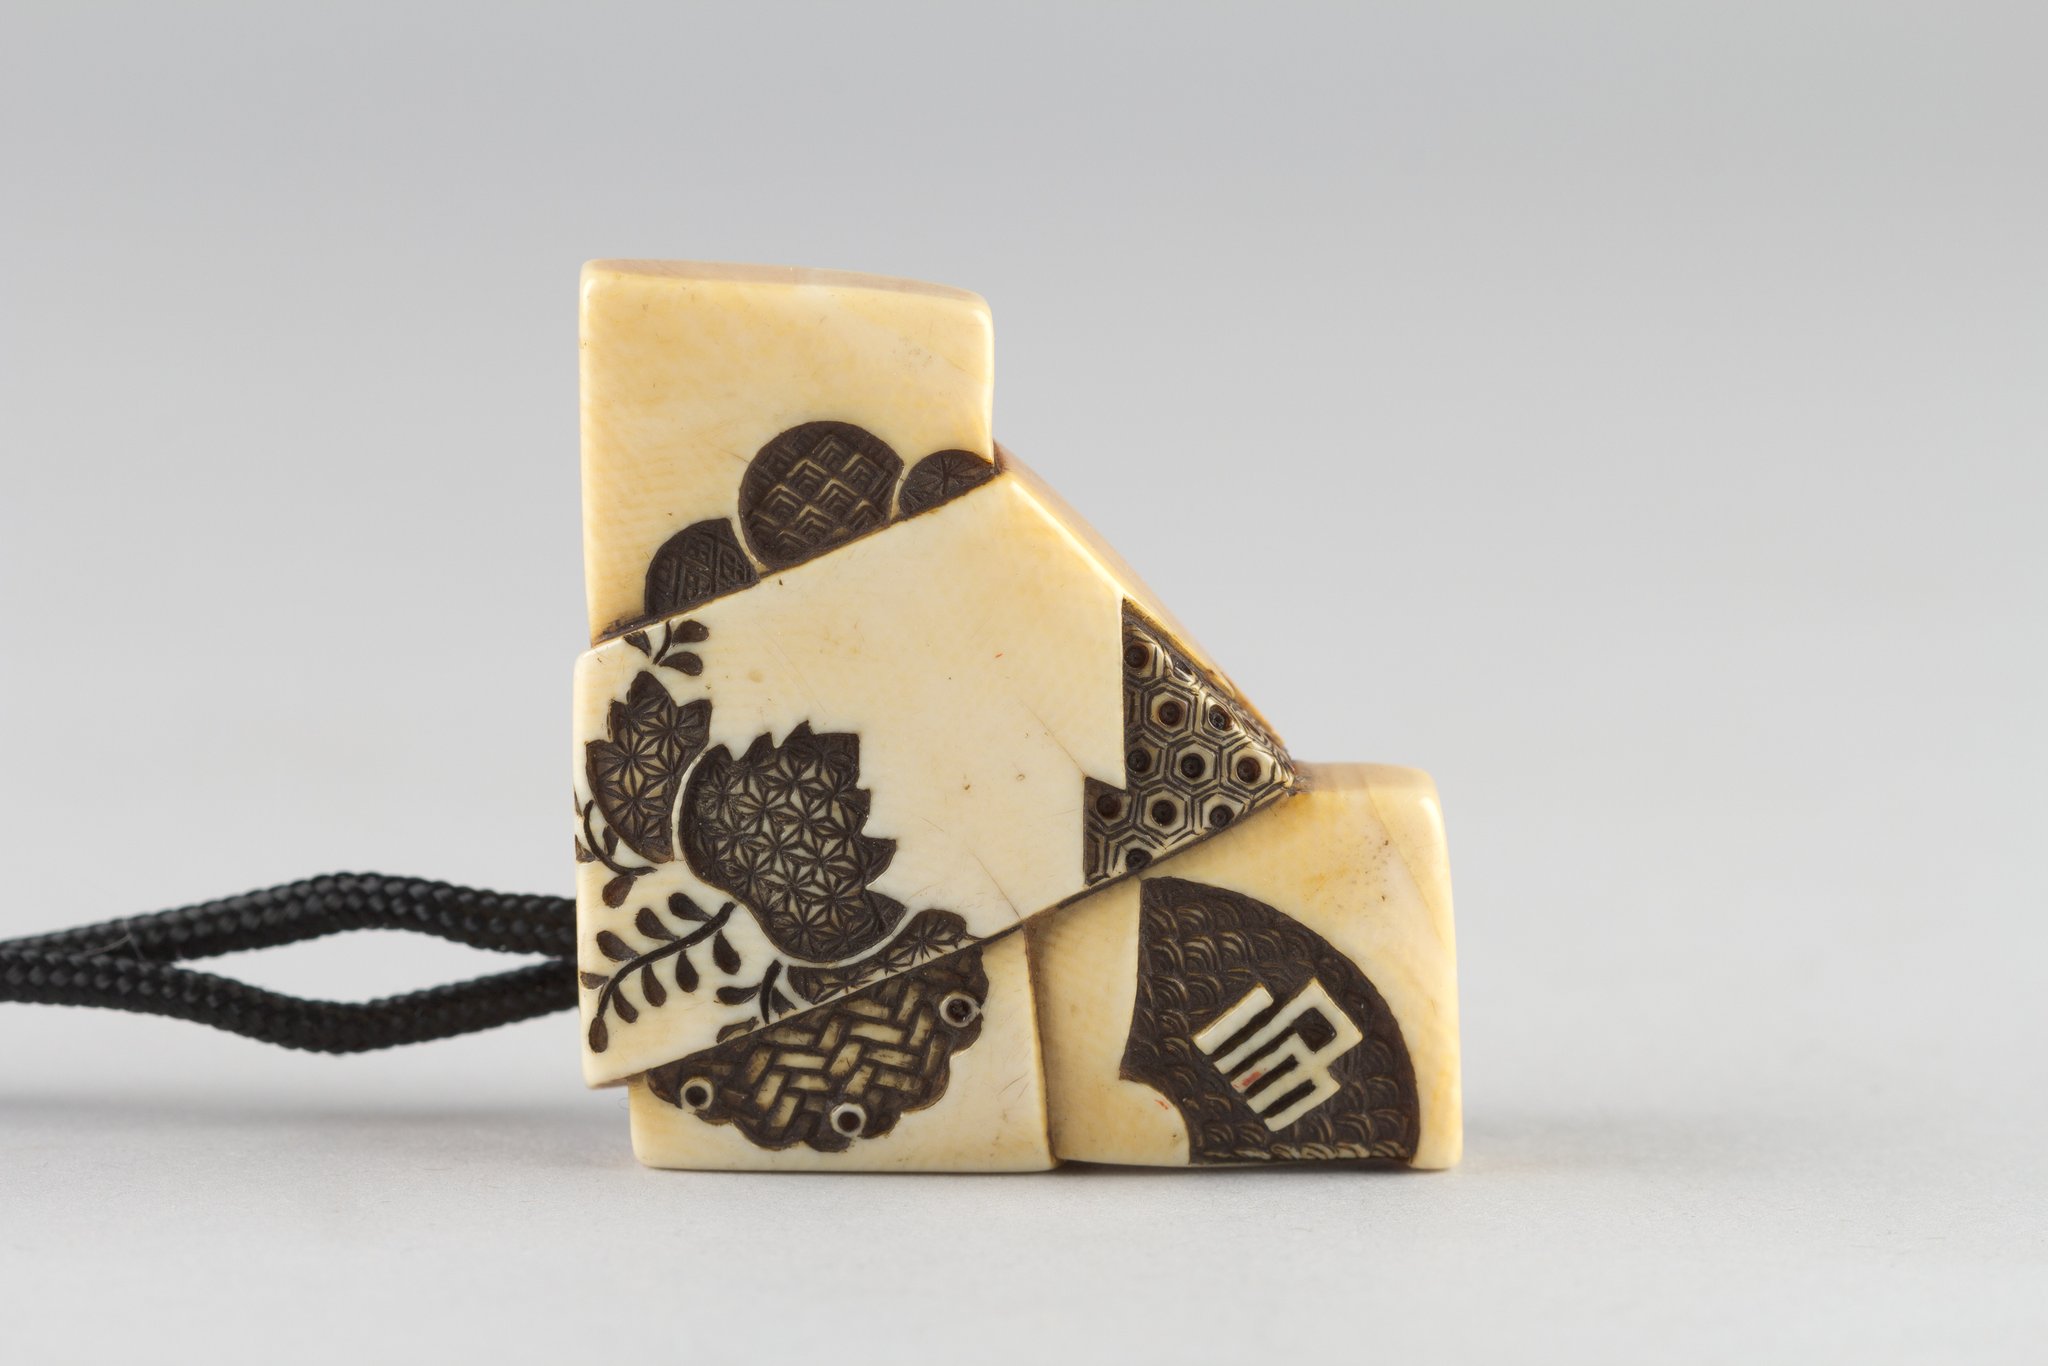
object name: netsuke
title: Netsuke Carved in Shape of Folded Letter on Paper Decorated with Court Motifs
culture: japanese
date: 1801-1900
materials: ivory